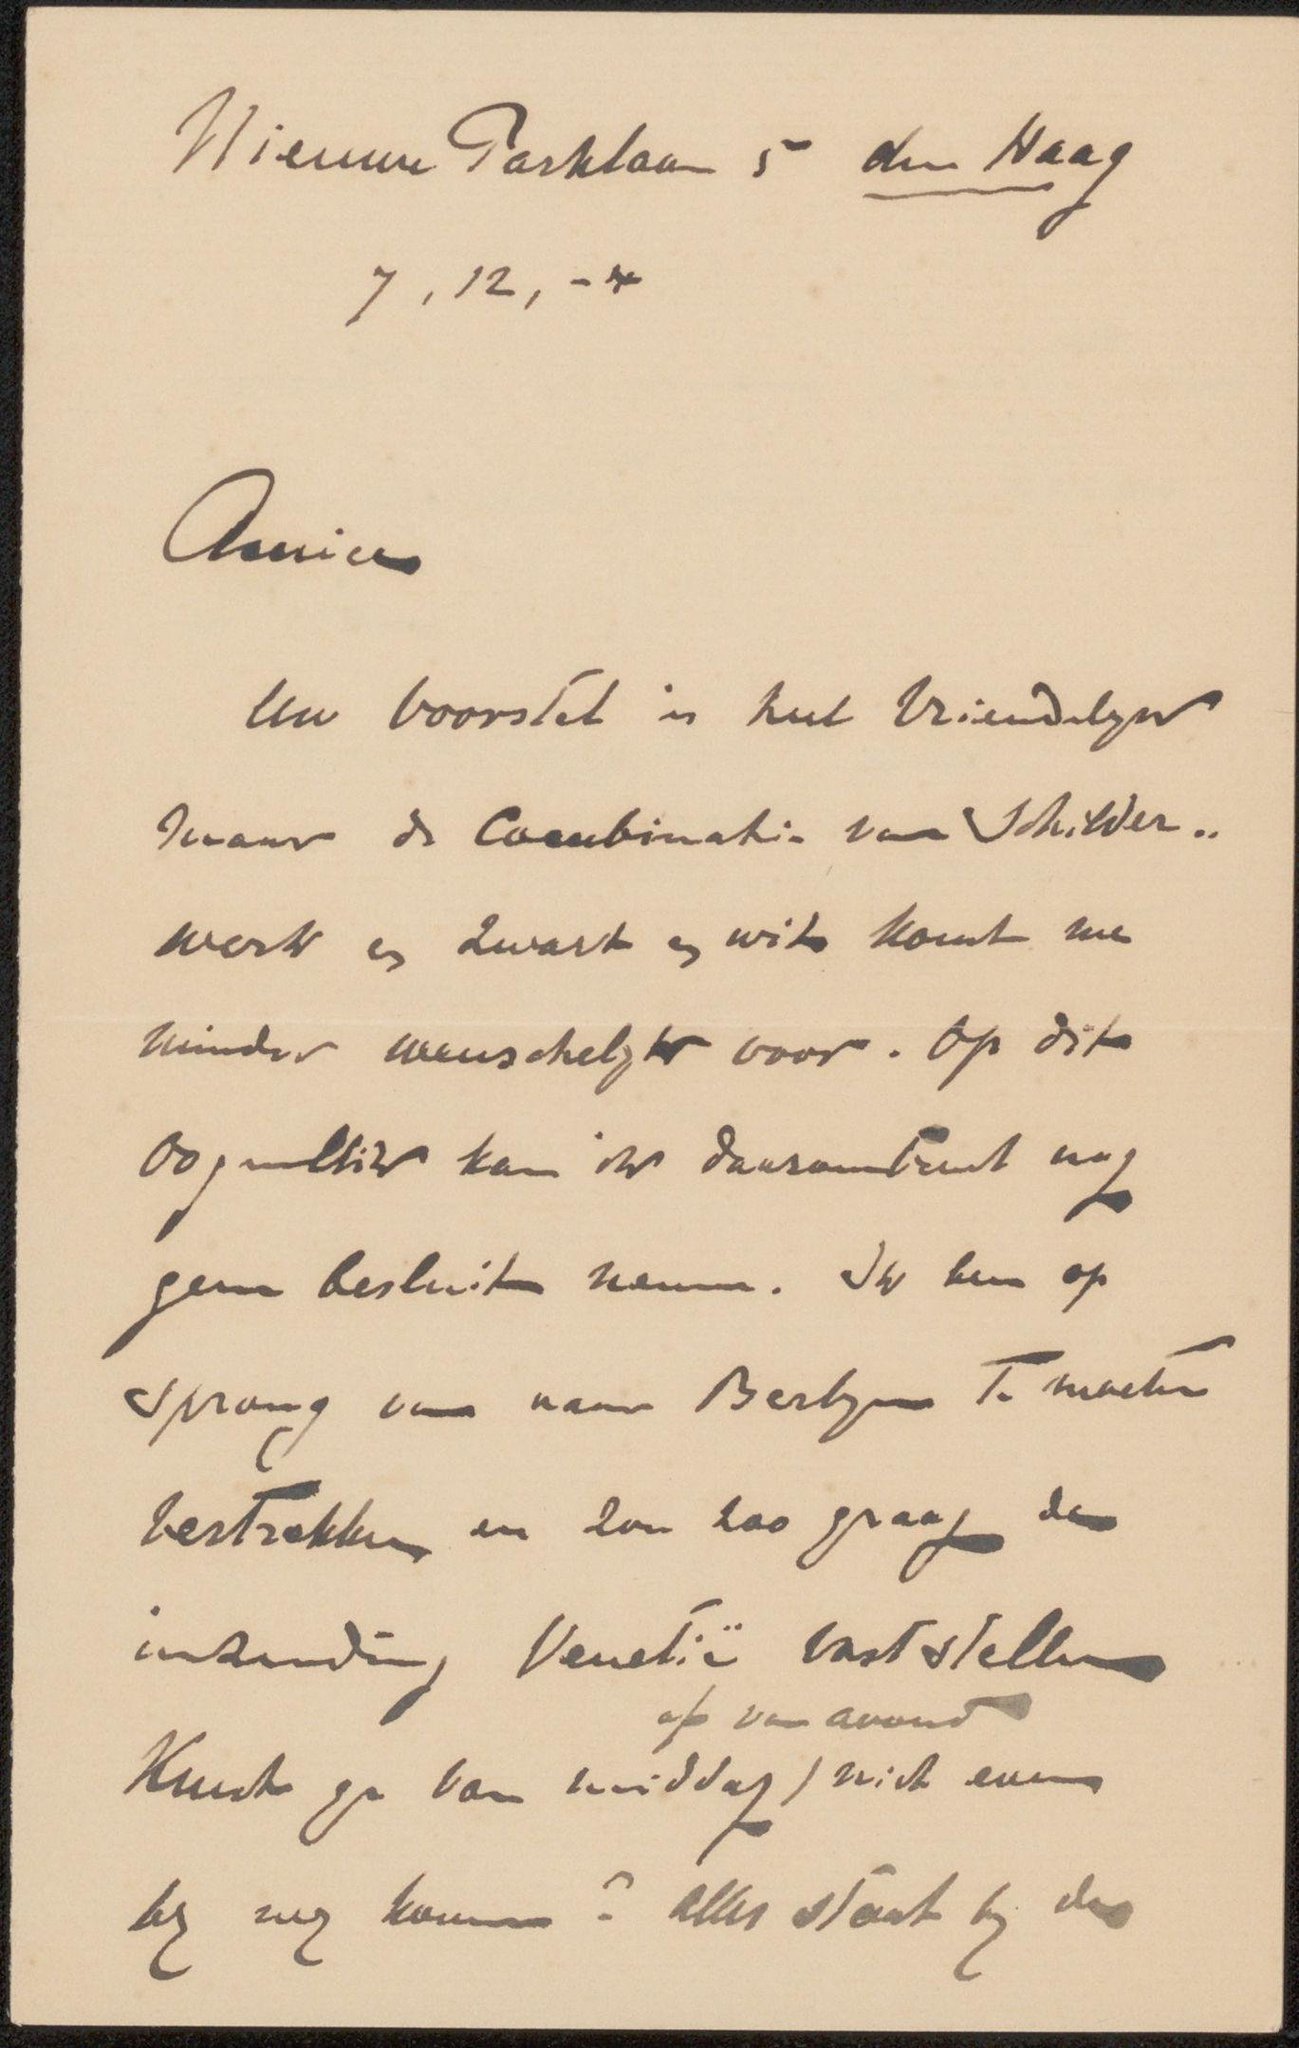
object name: letter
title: Brief aan Philip Zilcken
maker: carel nicolaas storm van s-gravesande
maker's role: draughtsman, print maker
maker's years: 1841-1924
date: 1904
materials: ink, paper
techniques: pen, writing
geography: the hague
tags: painter, draughtsman, philip zilcken, the graphic arts, painting (including book-illumination, miniature-painting), exhibition ~ art, venice, berlin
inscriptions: watermark, collector's mark: ‘RPK’